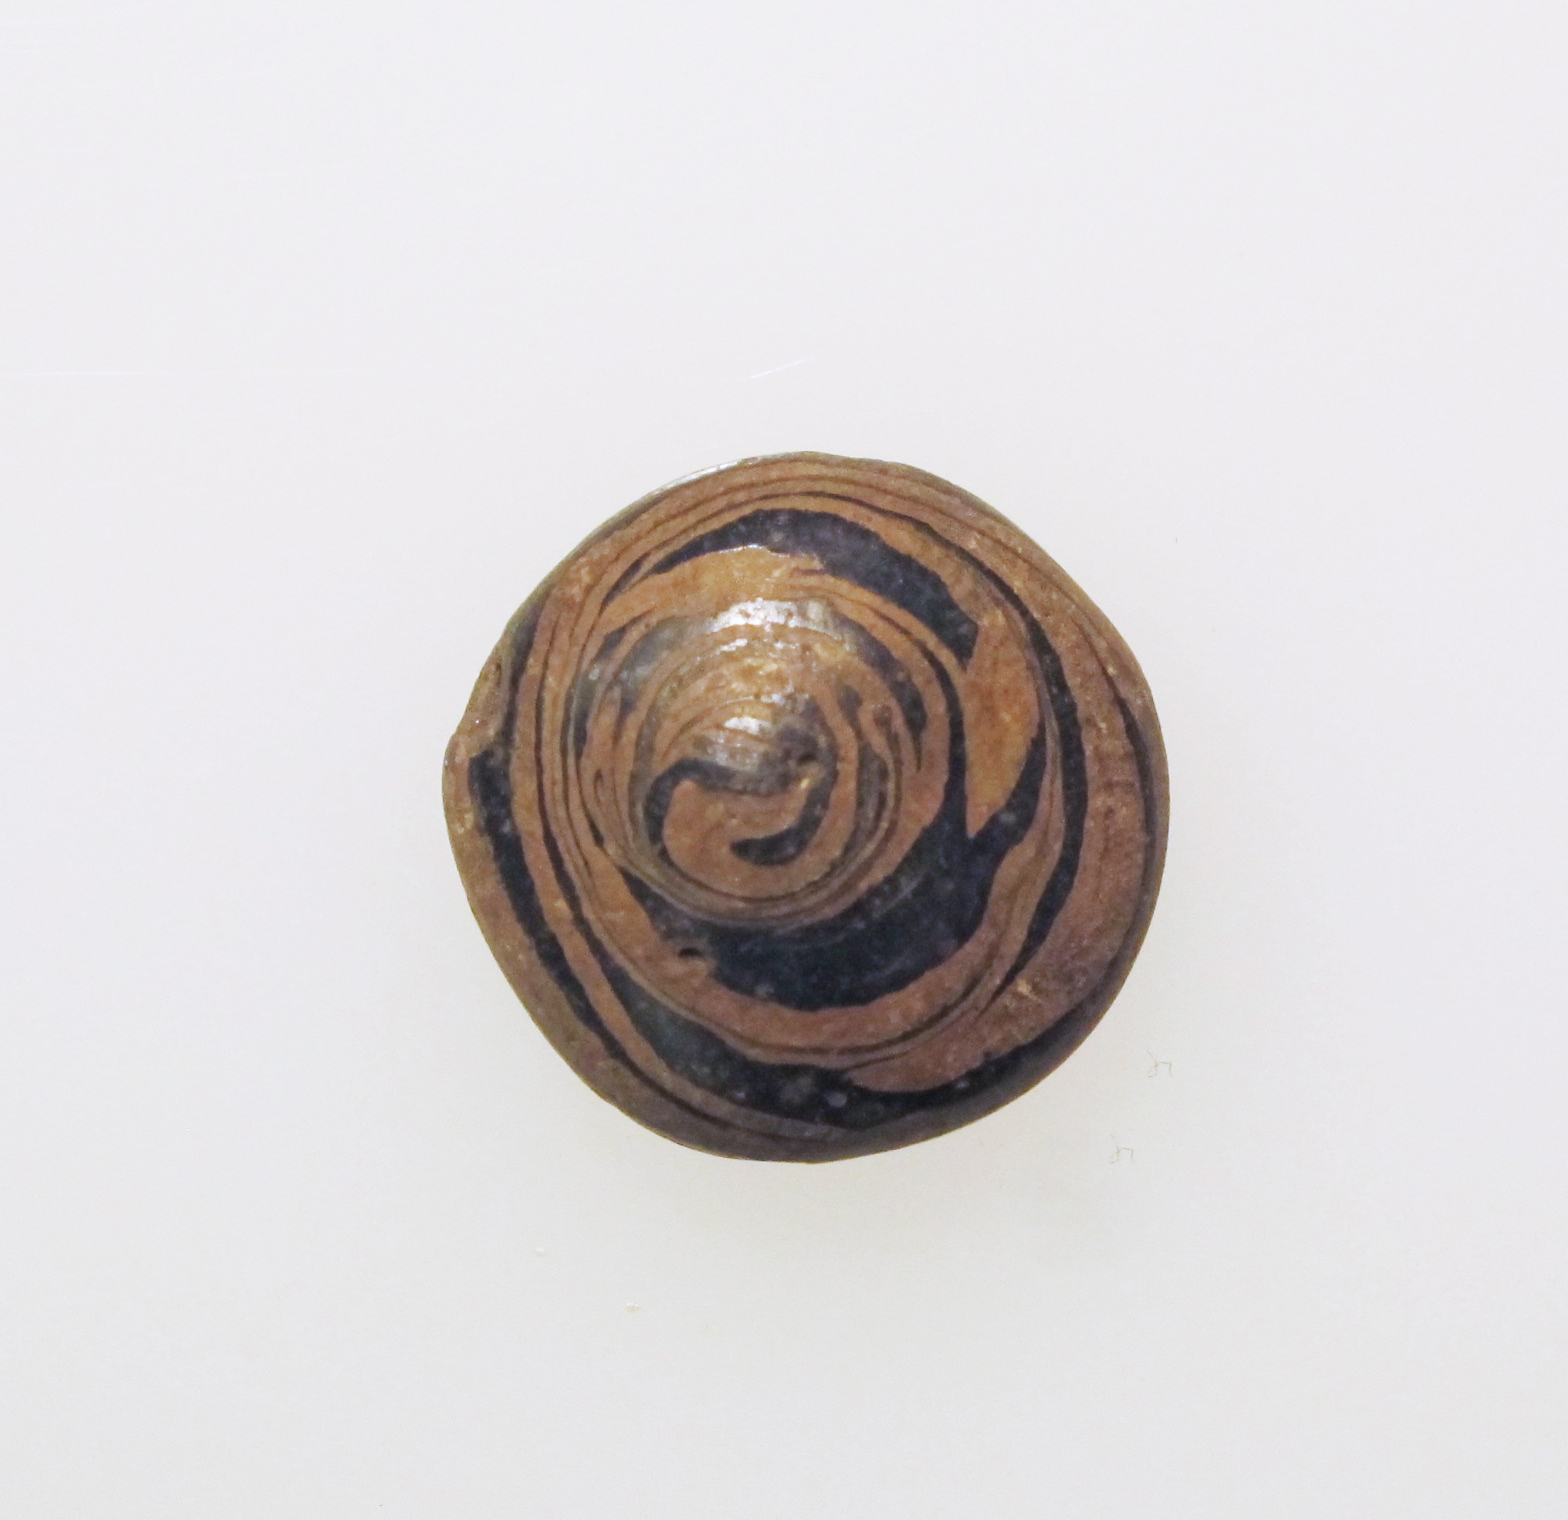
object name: pinhead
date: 7000 BCE-330 CE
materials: glass